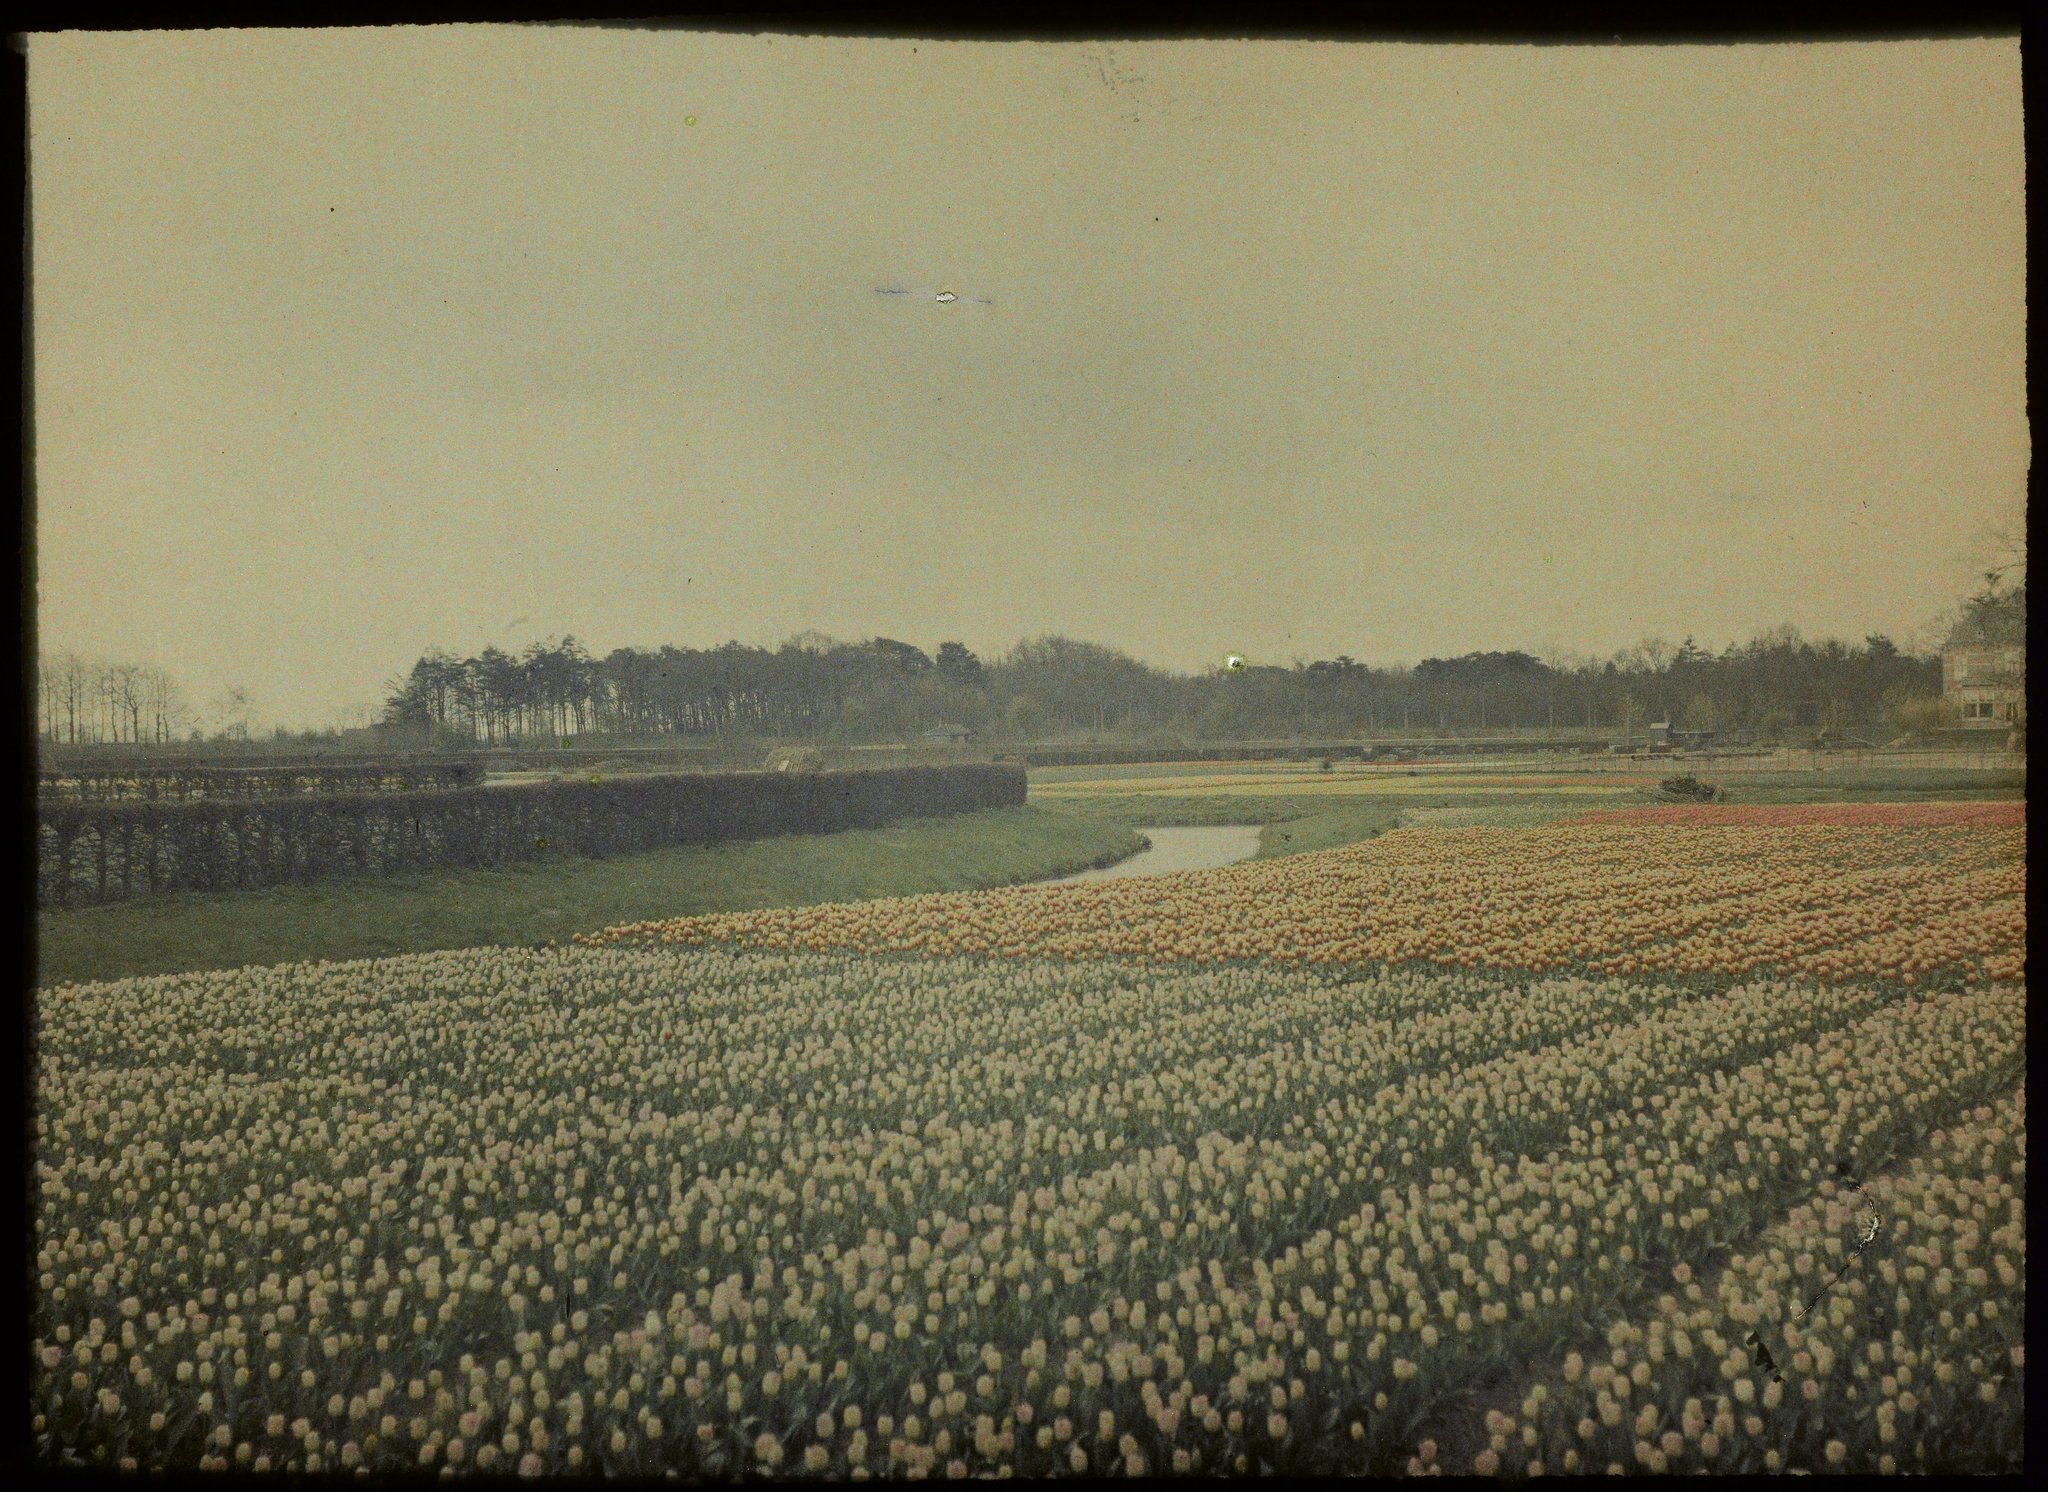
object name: color slide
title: Gezicht op een veld met hyacinthen, met een landhuis rechts op de achtergrond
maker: adolphe burdet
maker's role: fotograaf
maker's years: 1860-1940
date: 1907-1930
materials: glass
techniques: autochrome process, slide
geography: netherlands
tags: overveen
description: Gezicht op een veld met hyacinthen aan de Ramplaan te Overveen, met een landhuis rechts op de achtergrond.